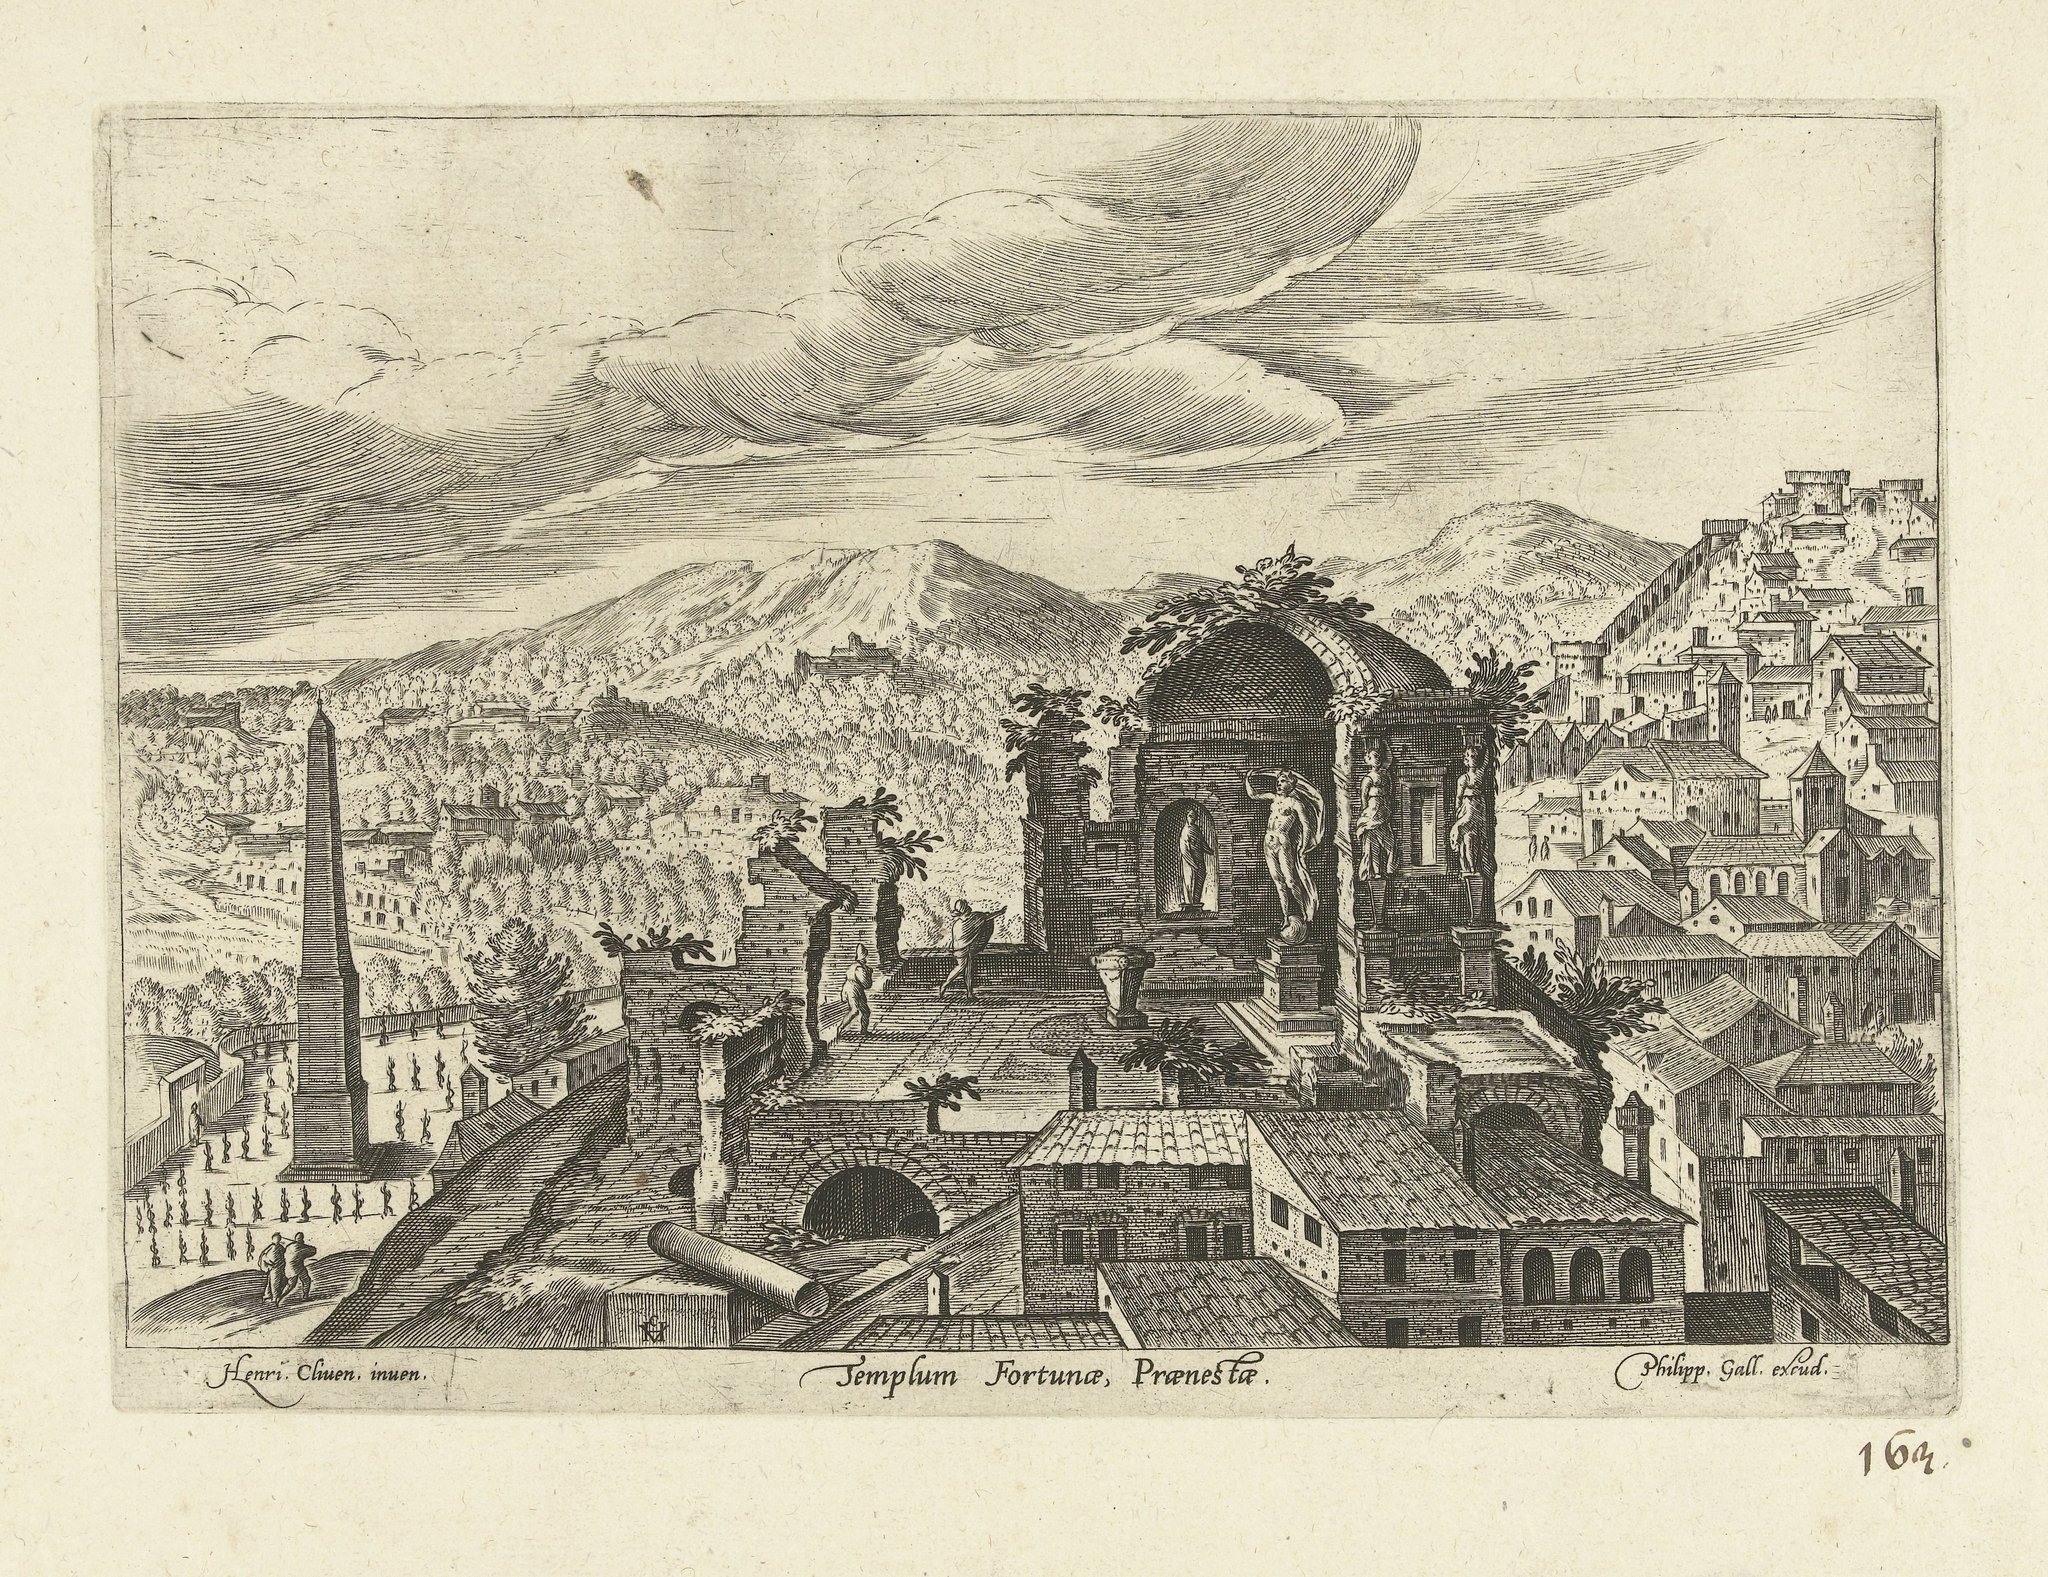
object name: print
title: Farnesiorum palatium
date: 1585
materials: paper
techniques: engraving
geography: antwerp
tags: ruin of a building ~ architecture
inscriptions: collector's mark: Lugt 2228, number: ‘164’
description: Gezicht op de stad Palestrina en de ruïnes van de tempel van Fortuna. De prent is deel van een serie die verschillende plaatsen in het Middellandse Zeegebied afbeeldt.